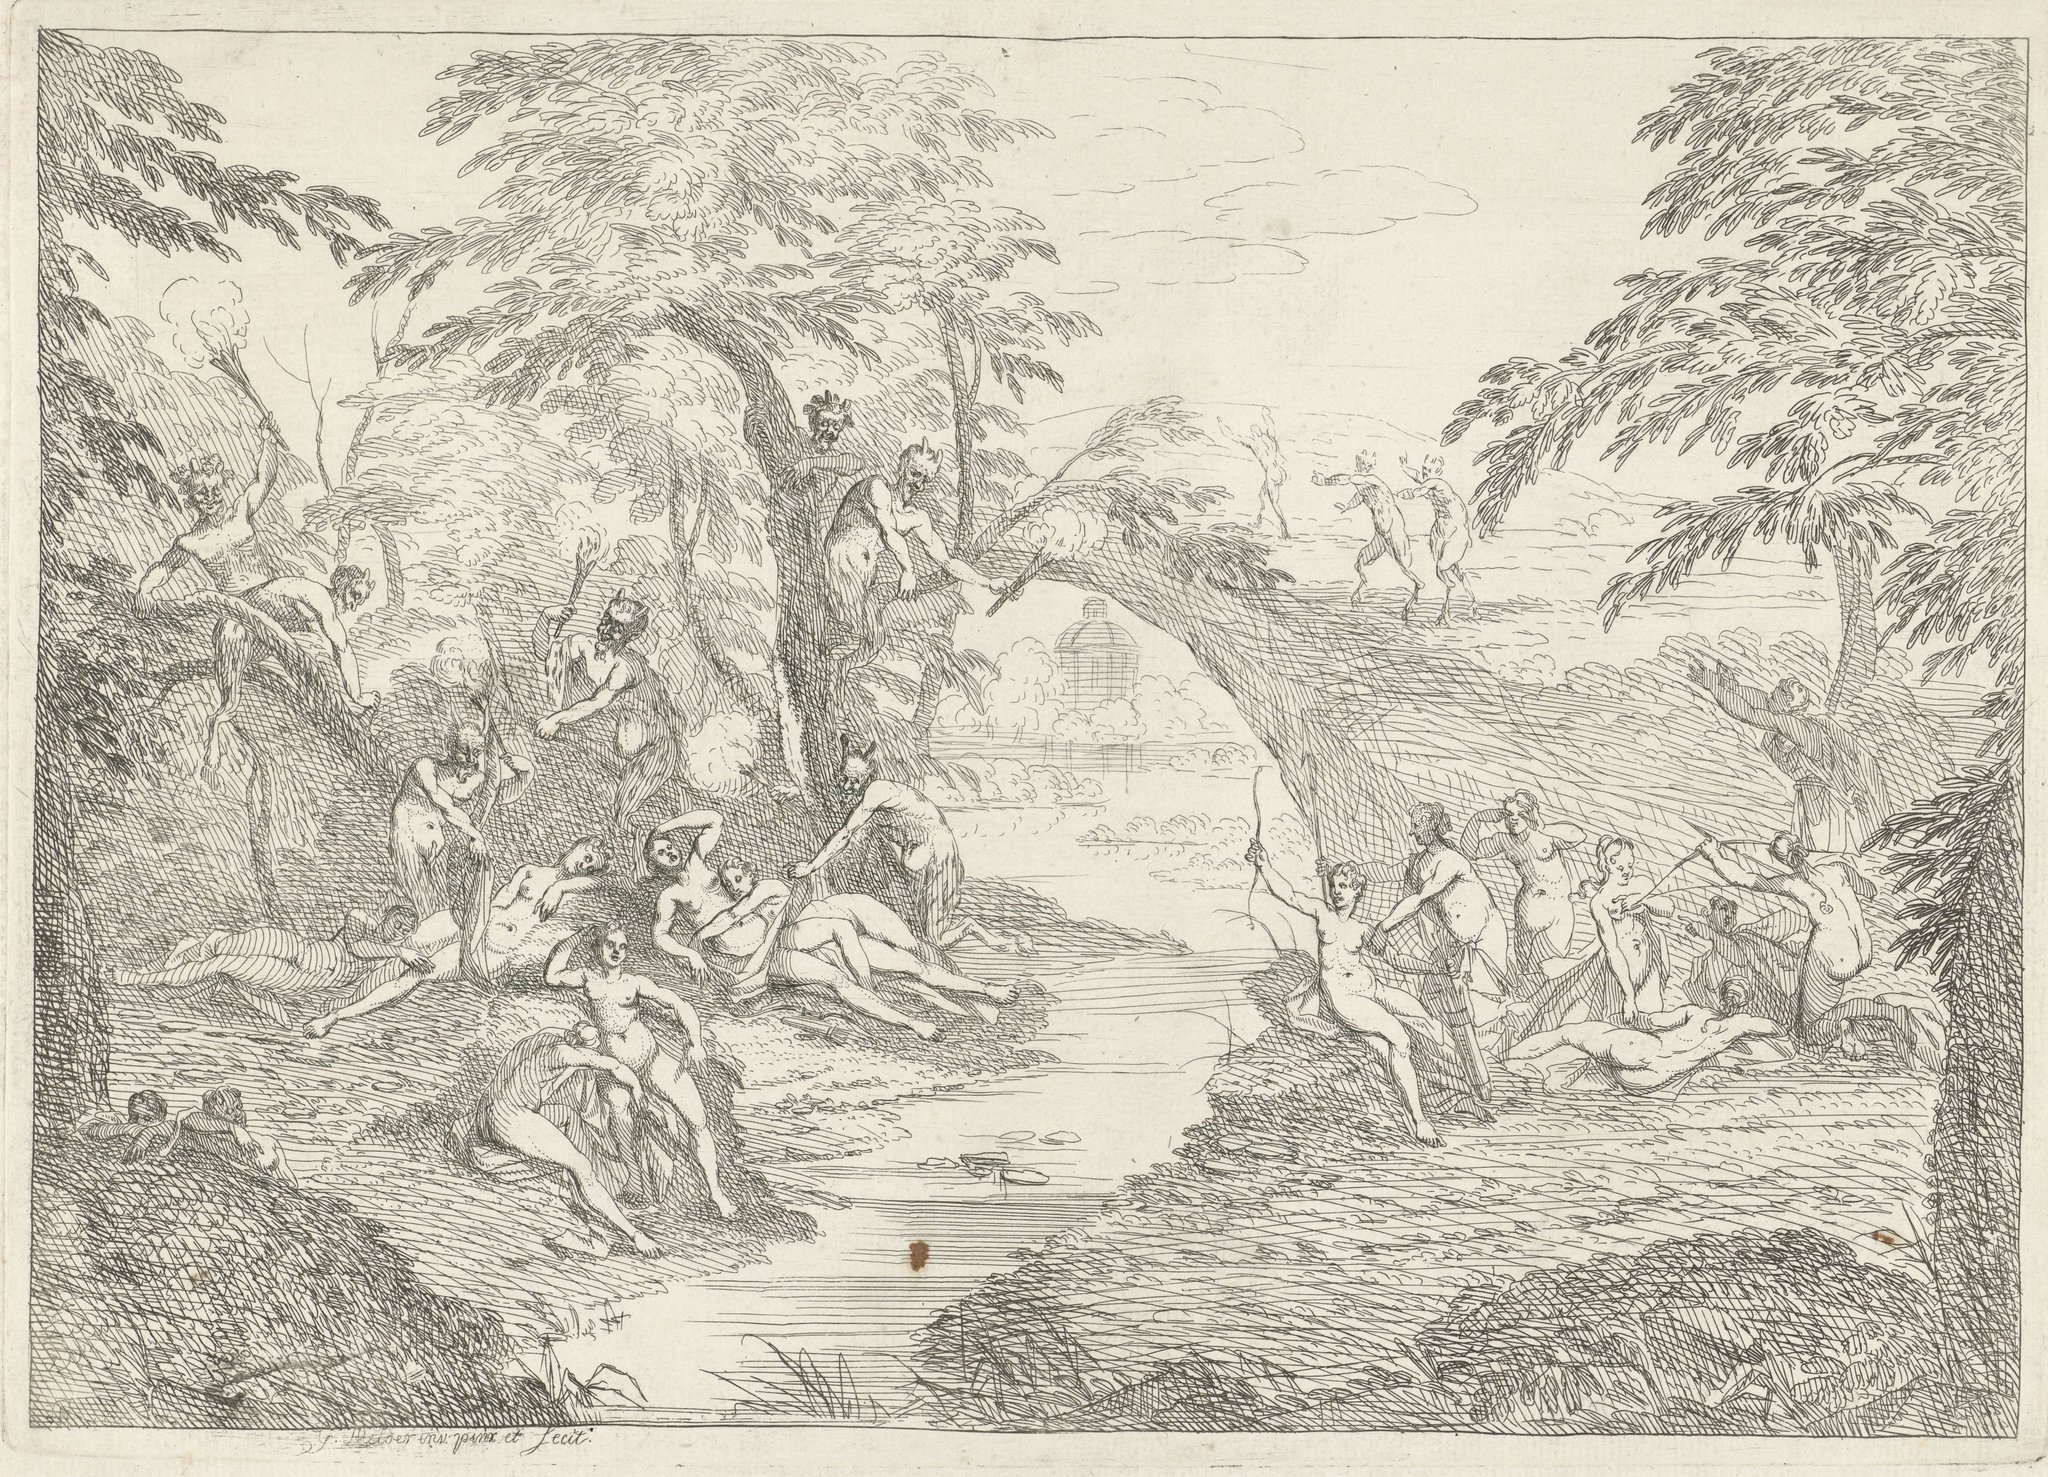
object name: print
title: Het leven der Bacchanten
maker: gerard melder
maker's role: painter, print maker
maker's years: 1693-1754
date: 1725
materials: paper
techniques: etching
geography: amsterdam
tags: satyr(s) pursuing nymph(s)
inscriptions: collector's mark: Lugt 2228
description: Een groep nimfen bij een beek. Saters bespieden de nimfen vanuit bomen. Ze dragen fakkels in hun handen. Aan de rechter oever schiet een nimf met pijl en boog op drie vluchtende saters.